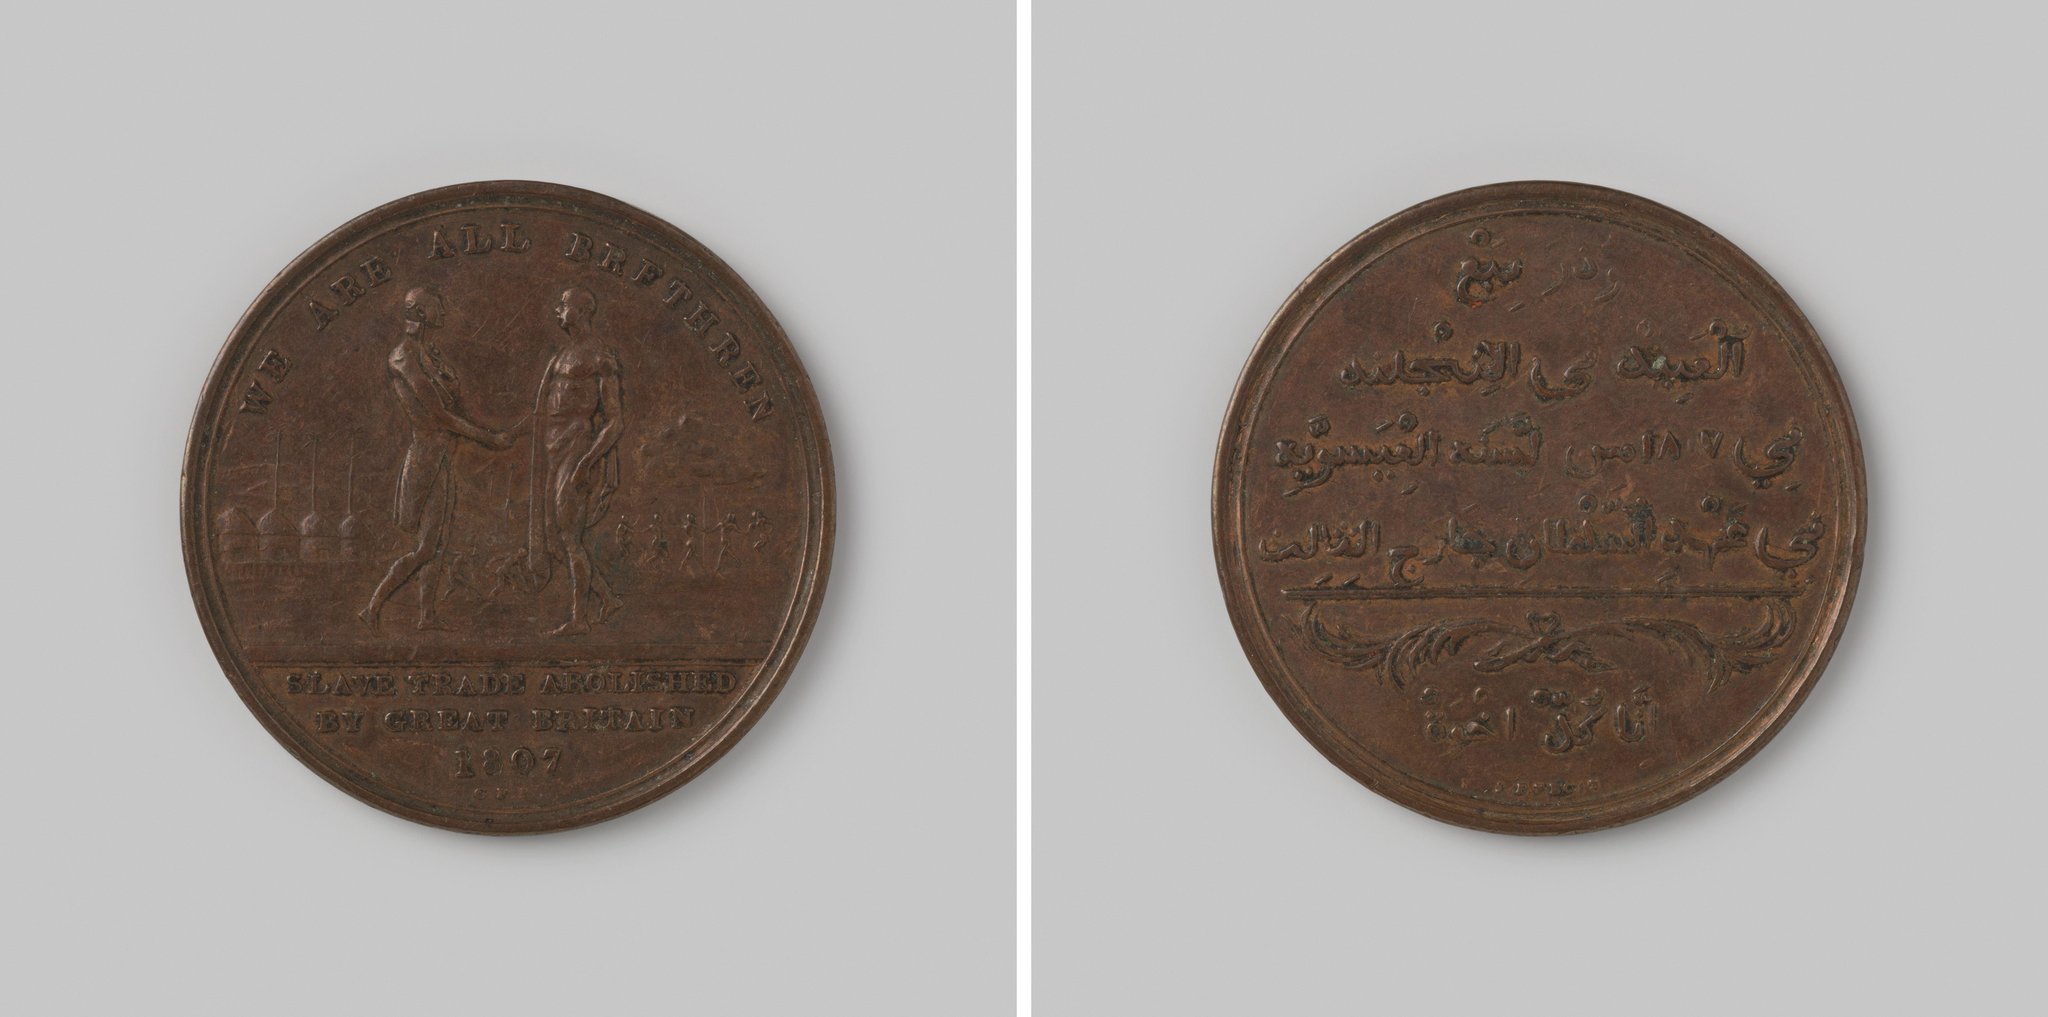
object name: history medal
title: Afschaffing van de slavenhandel in Engeland 1807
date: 1807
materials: copper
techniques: striking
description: Koperen penning, op de voorzijde een Engelsman en een Afrikaan die elkaar de hand drukken, op de achtergrond links een huttendorp, in het midden arbeiders, en rechts dansers om de vrijheidsboom, met omschrift en afsnedetekst, op de keerzijde drie regels Perzisch schrift boven een dubbele streep, daaronder twee samengestrikte palmtakken en nog een regel Perzisch schrift.